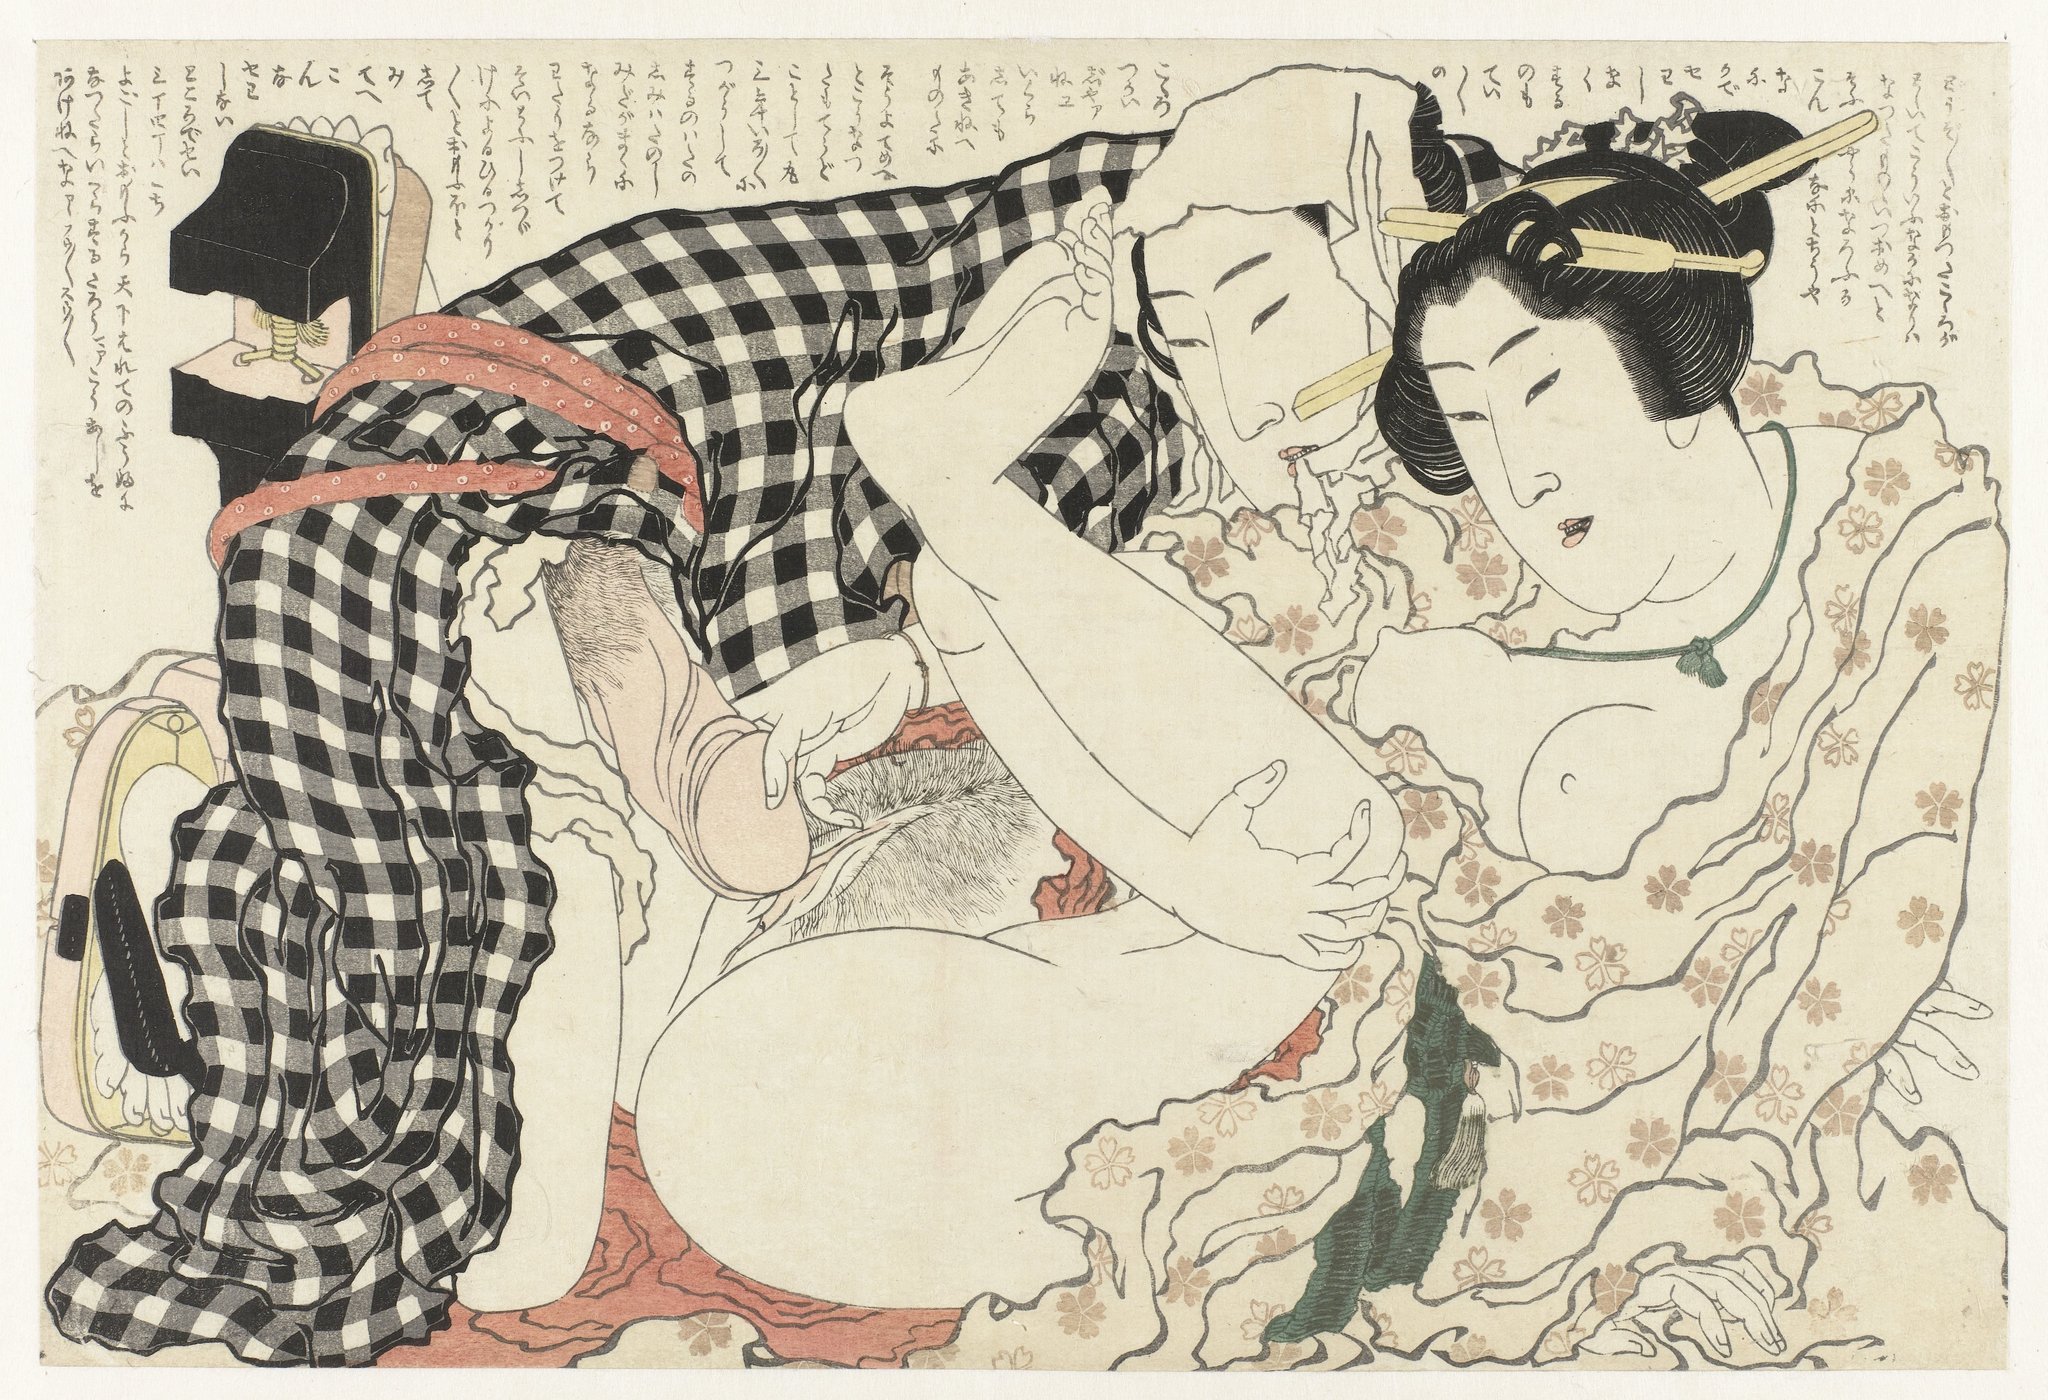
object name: print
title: De Adonis plant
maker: katsushika hokusai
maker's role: draughtsman, print maker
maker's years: 1760-1849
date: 1815-1823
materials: paper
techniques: blind stamped, woodcut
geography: japan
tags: man and woman cohabiting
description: Man in zwart-wit geblokte kimono en hoofddoek, de liefde bedrijvend met jonge vrouw, in de buitenlucht.